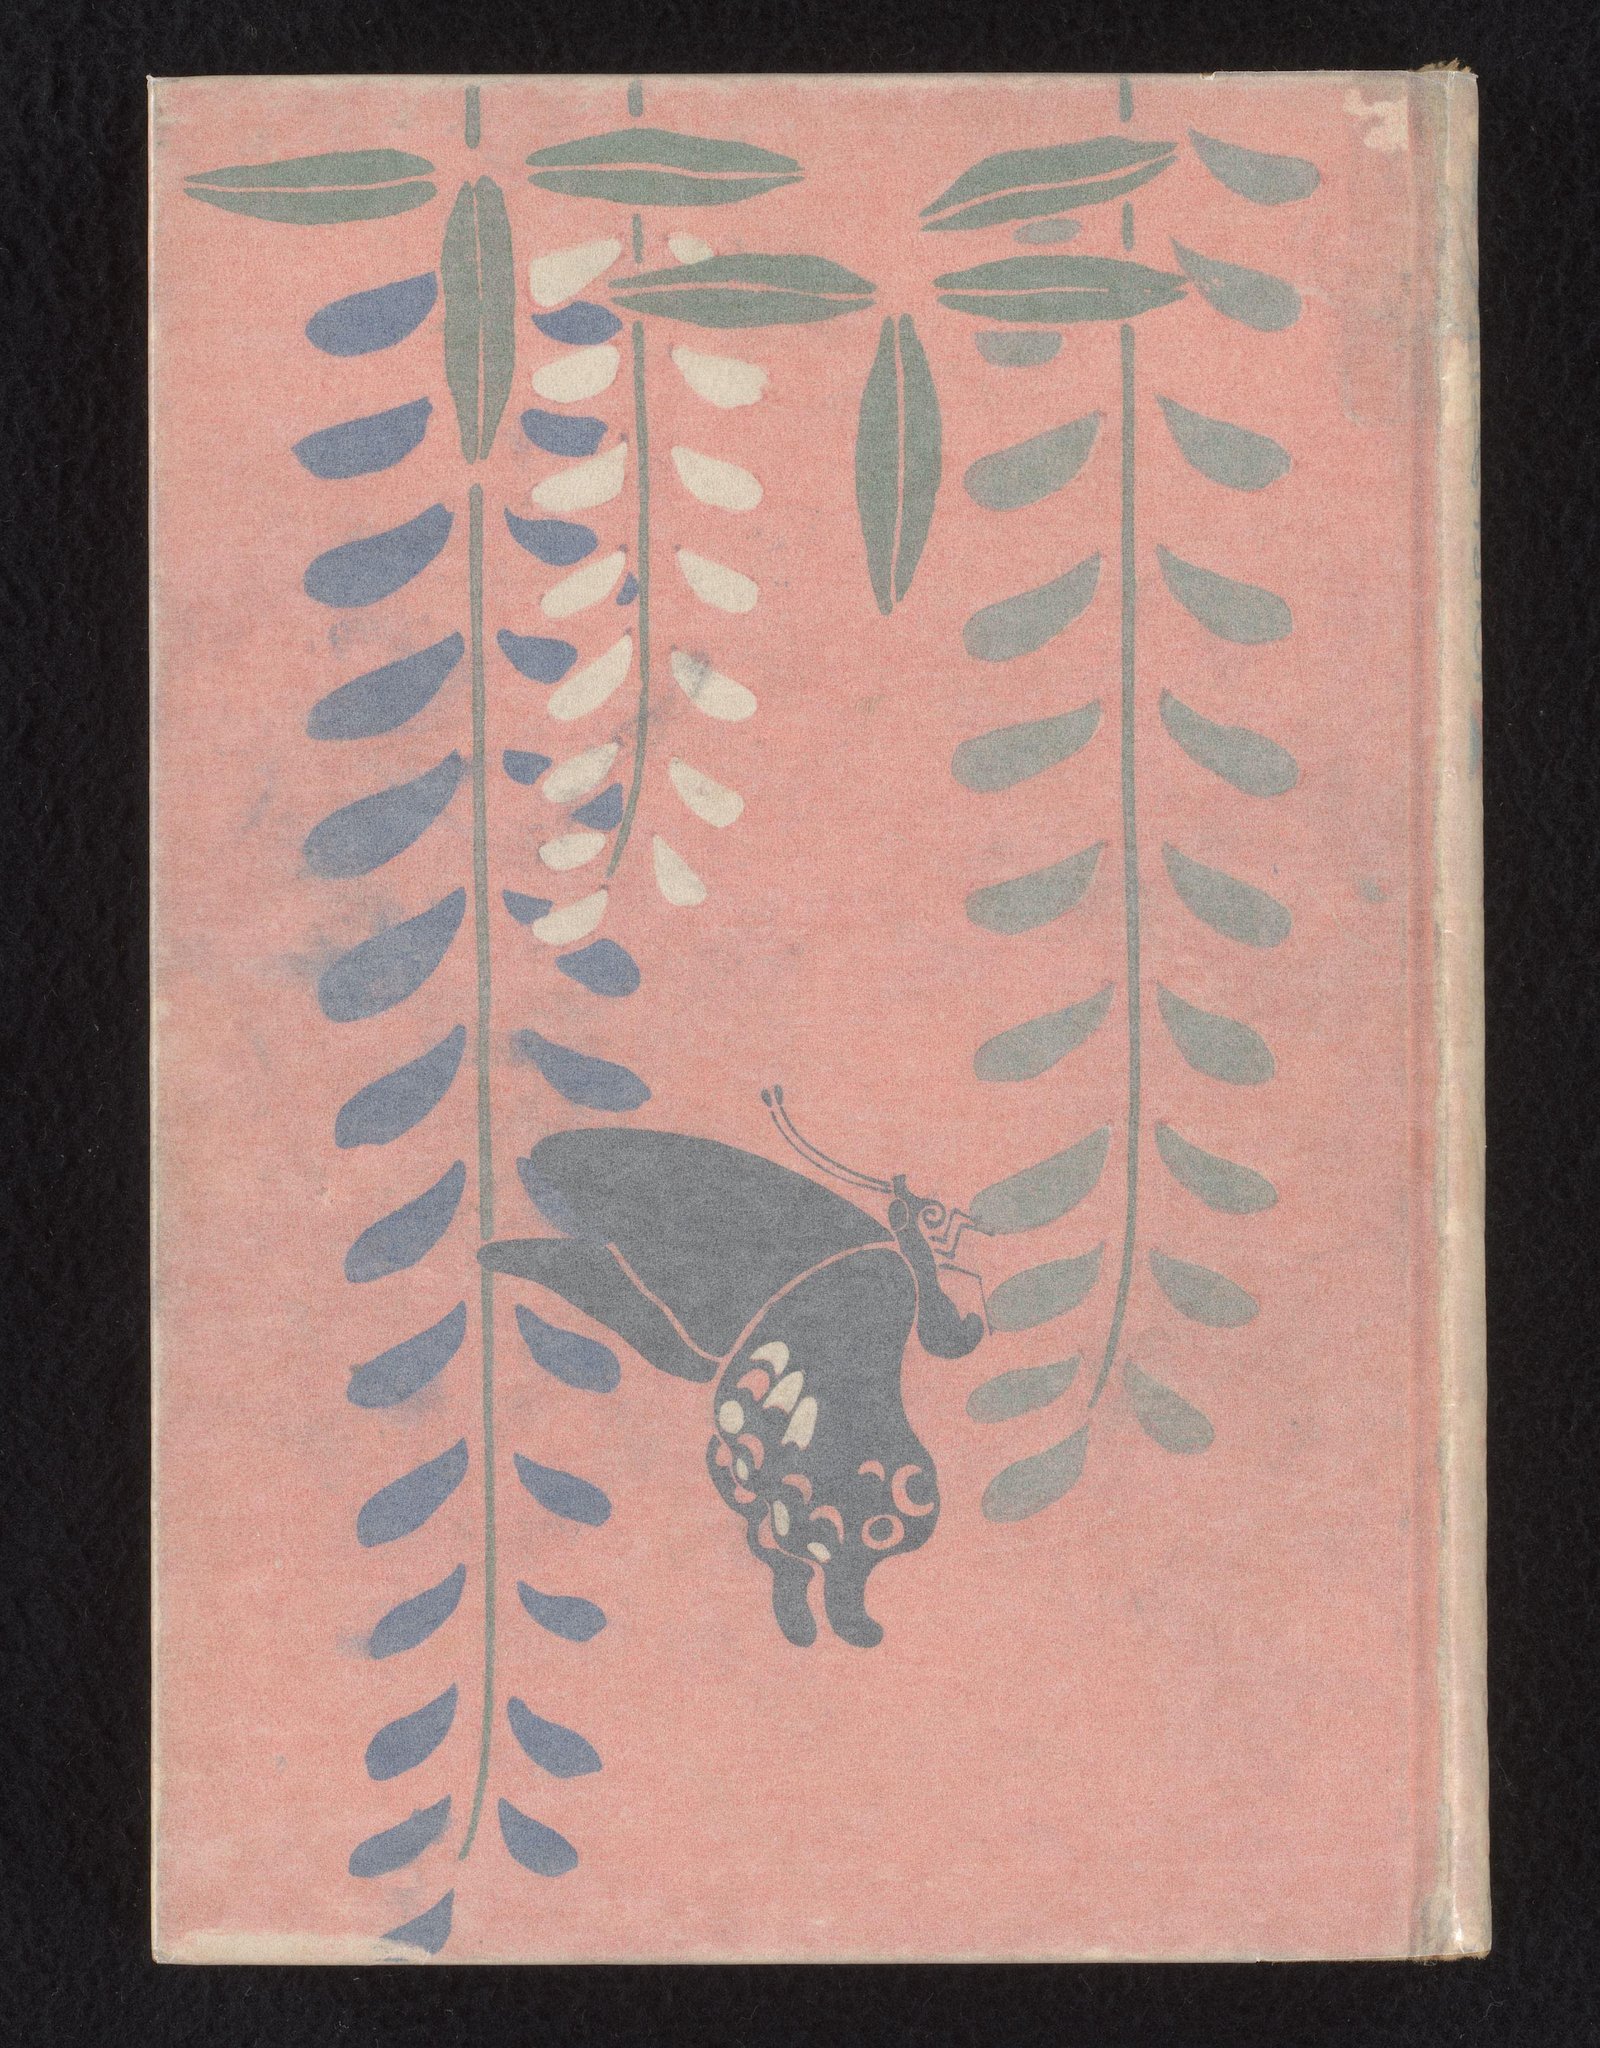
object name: book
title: Nasanunaka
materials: paper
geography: japan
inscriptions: date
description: Part one from a novel complete in three volumes and a sequel. Slipcase, book cover and endpapers are designed by Sugiura Hisui; Two frontispiece colour woodcuts by Eiho.